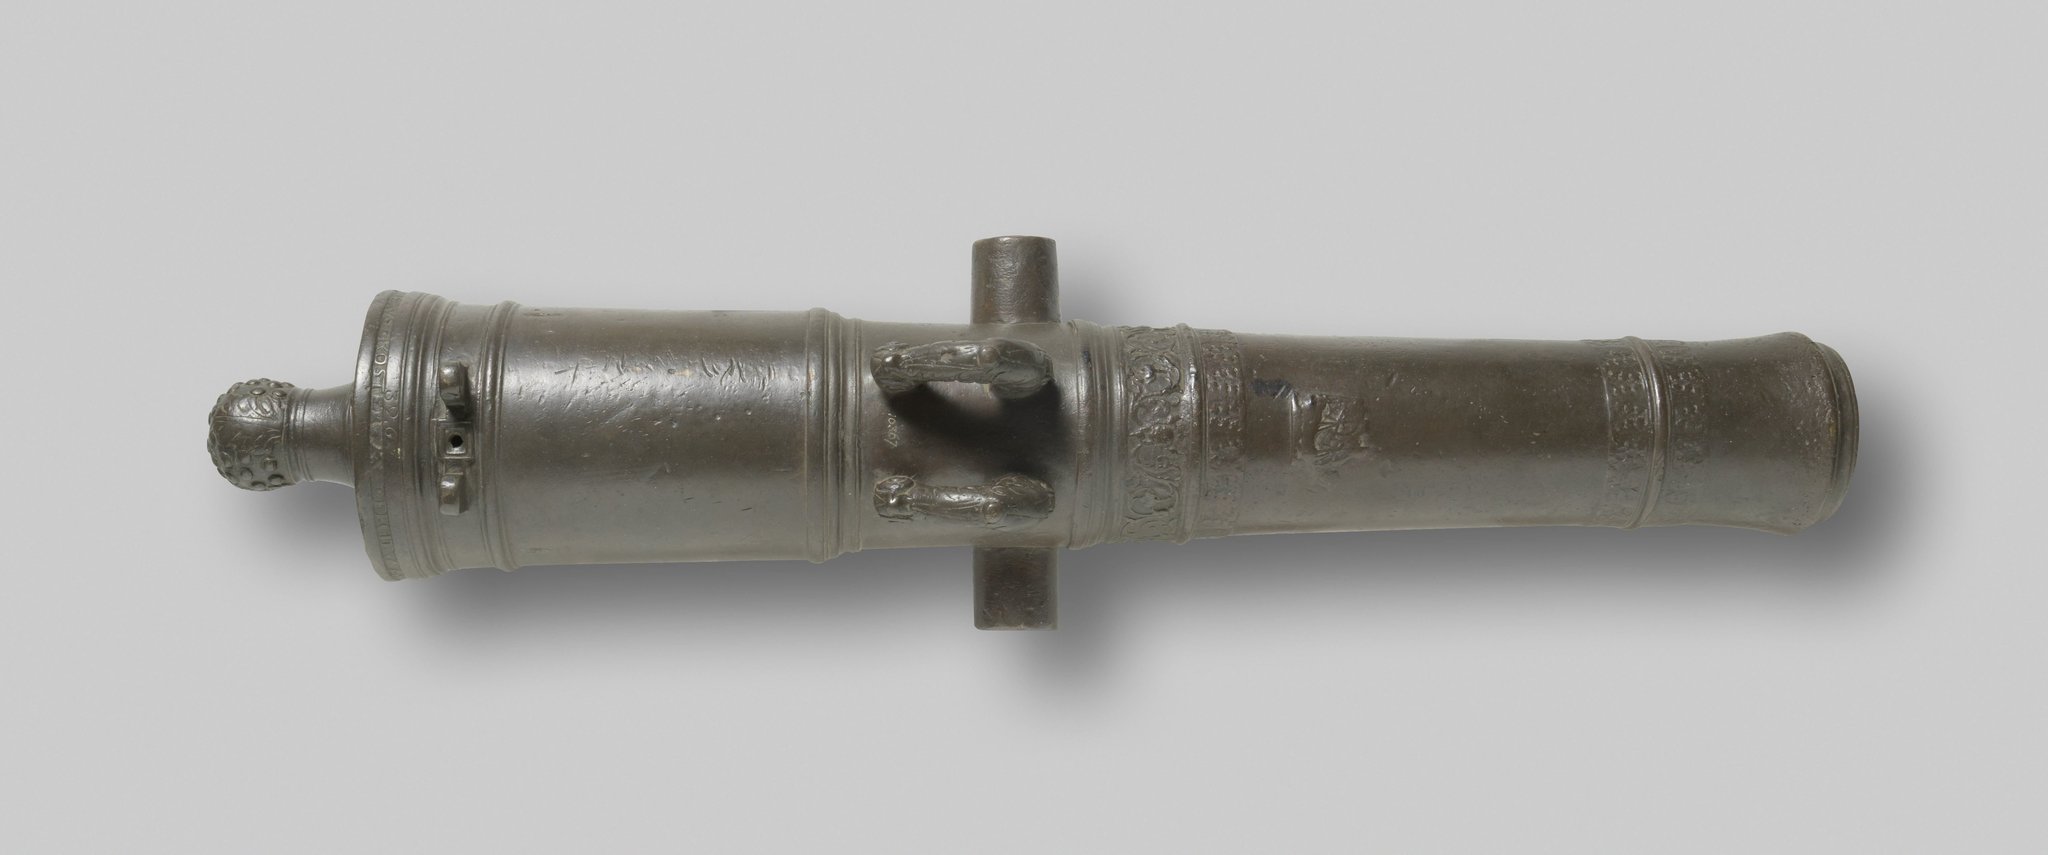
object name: cannon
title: Bronzen kanon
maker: assverus koster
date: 1633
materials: bronze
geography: amsterdam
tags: compagnie van verre, lombok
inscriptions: inscription: ‘326’, inscription: ‘ASSVERUS.KOSTER.M.FECIT.AMSTELREDAMI.1633’, : ‘voorstelling van een zeilende Oost-Indië vaarder’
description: Bronzen kanon met oren in de vorm van dolfijnen. Op het langeveld een figuur in reliëf in de vorm van een zeilende Oost-Indië vaarder, een verwijzing naar de Compagnie van Verre. Banden met arabesken ook bladkransen. De druif heeft de vorm van een druiventros met wingerdbladeren. Tegen het bodemstuk drie lelies en drie acanthusbladeren. De nokken van het zundgat zijn relatief groot.